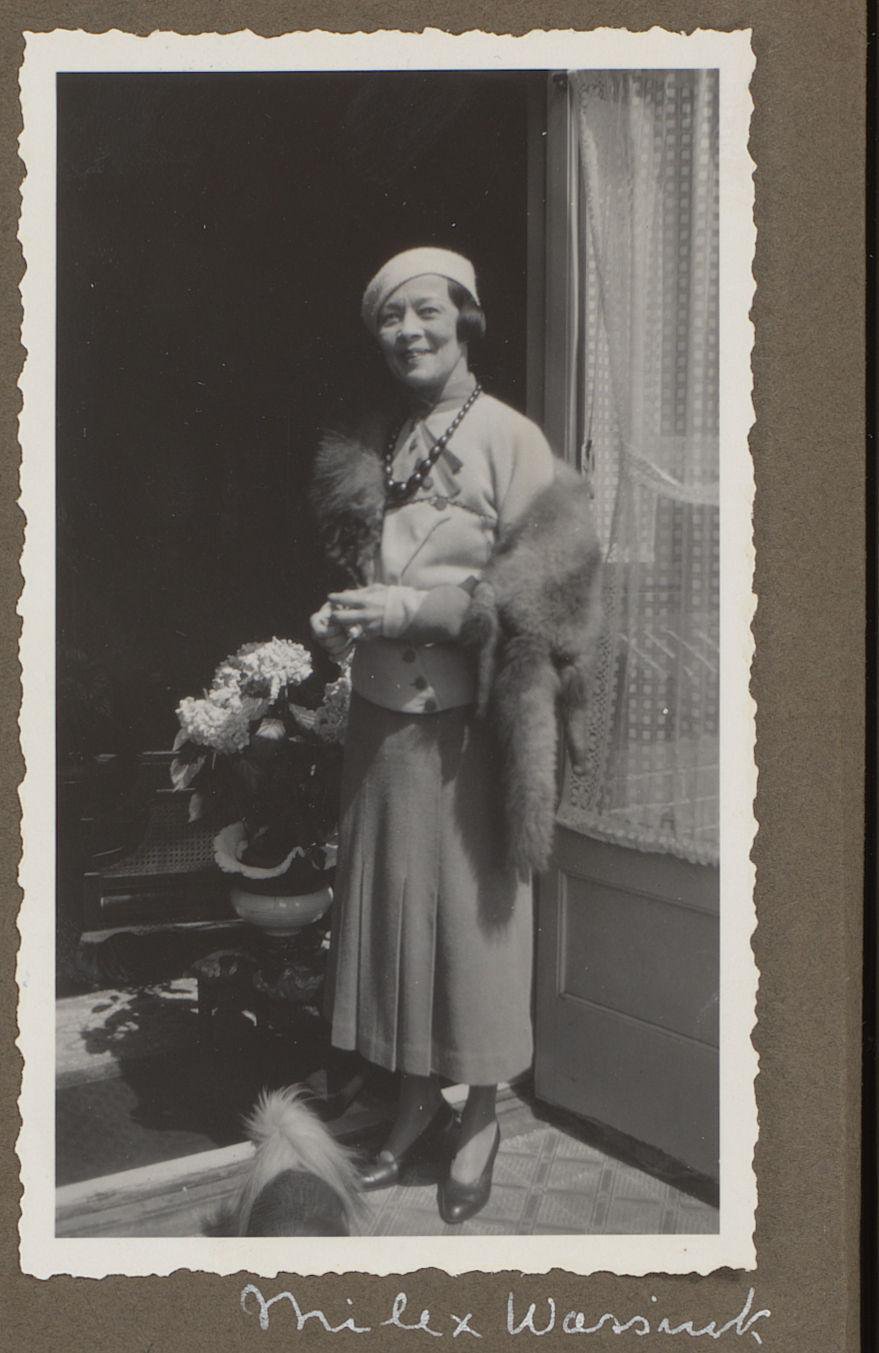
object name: photograph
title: Portret van Milex Wassink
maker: Anonymous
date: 1907-1933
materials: paper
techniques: gelatin silver print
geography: the hague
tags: historical persons not known by name - bb - woman, the hague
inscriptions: inscription: ‘Mi Lex Wassink’